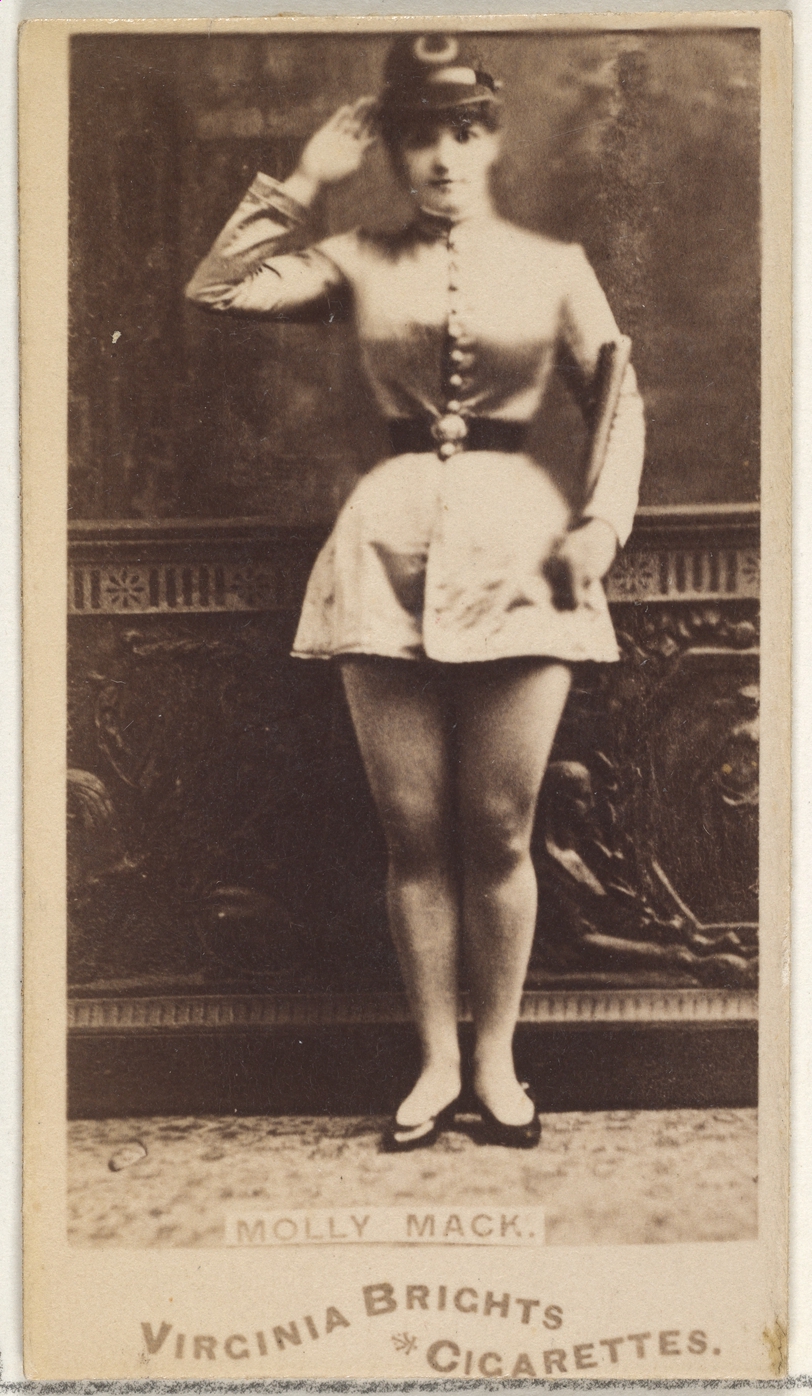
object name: photograph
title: Molly Mack, from the Actors and Actresses series (N45, Type 1) for Virginia Brights Cigarettes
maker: allen & ginter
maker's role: publisher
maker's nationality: american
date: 1888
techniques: albumen silver print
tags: portraits,women,actresses